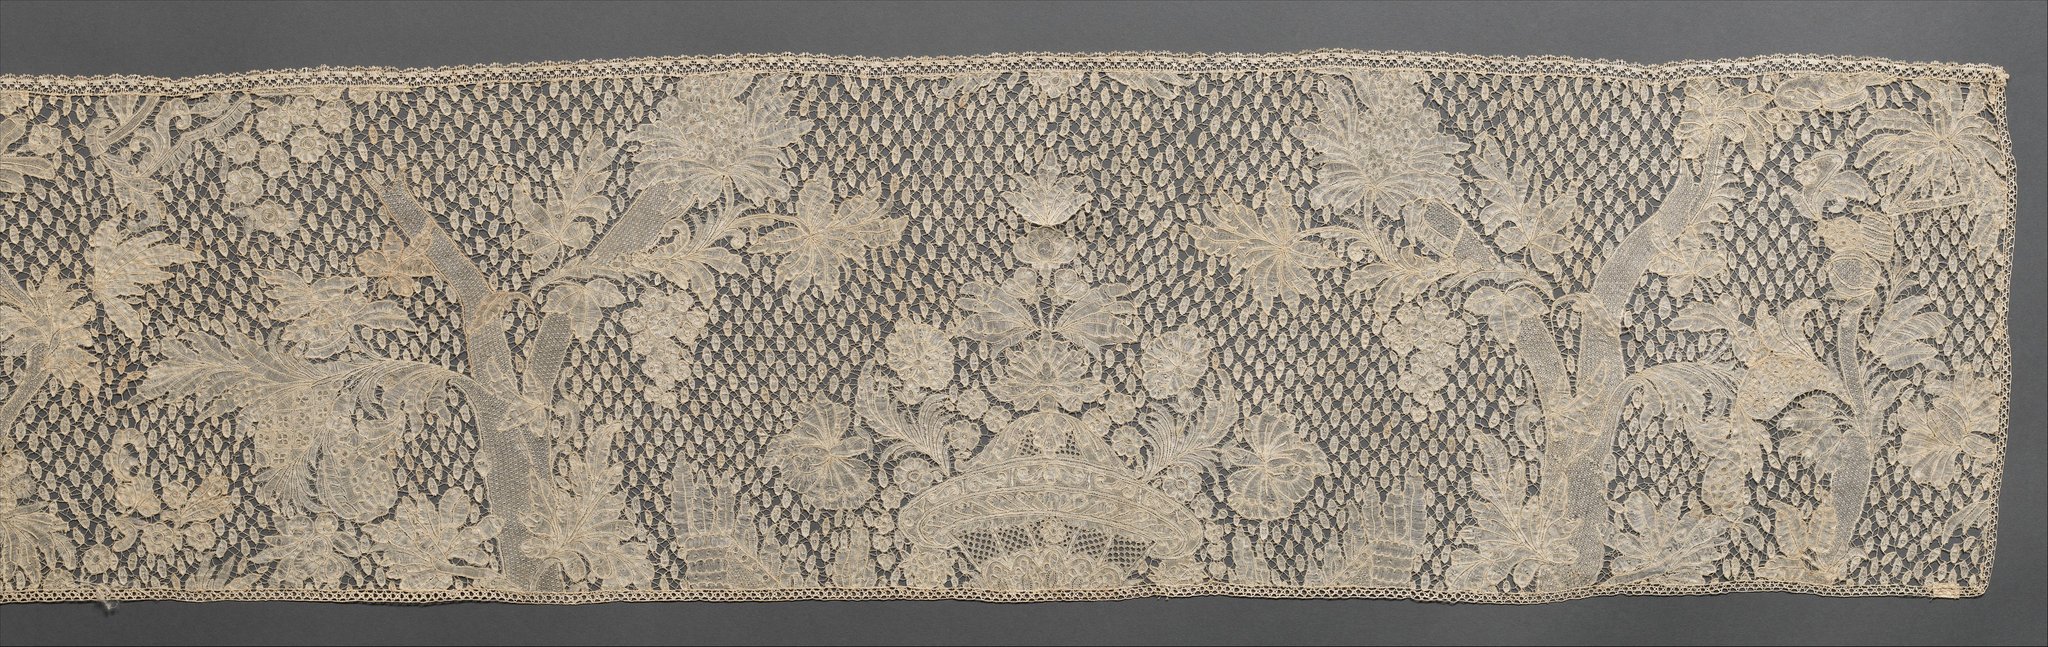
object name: flounce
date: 1750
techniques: lace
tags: flowers,trees